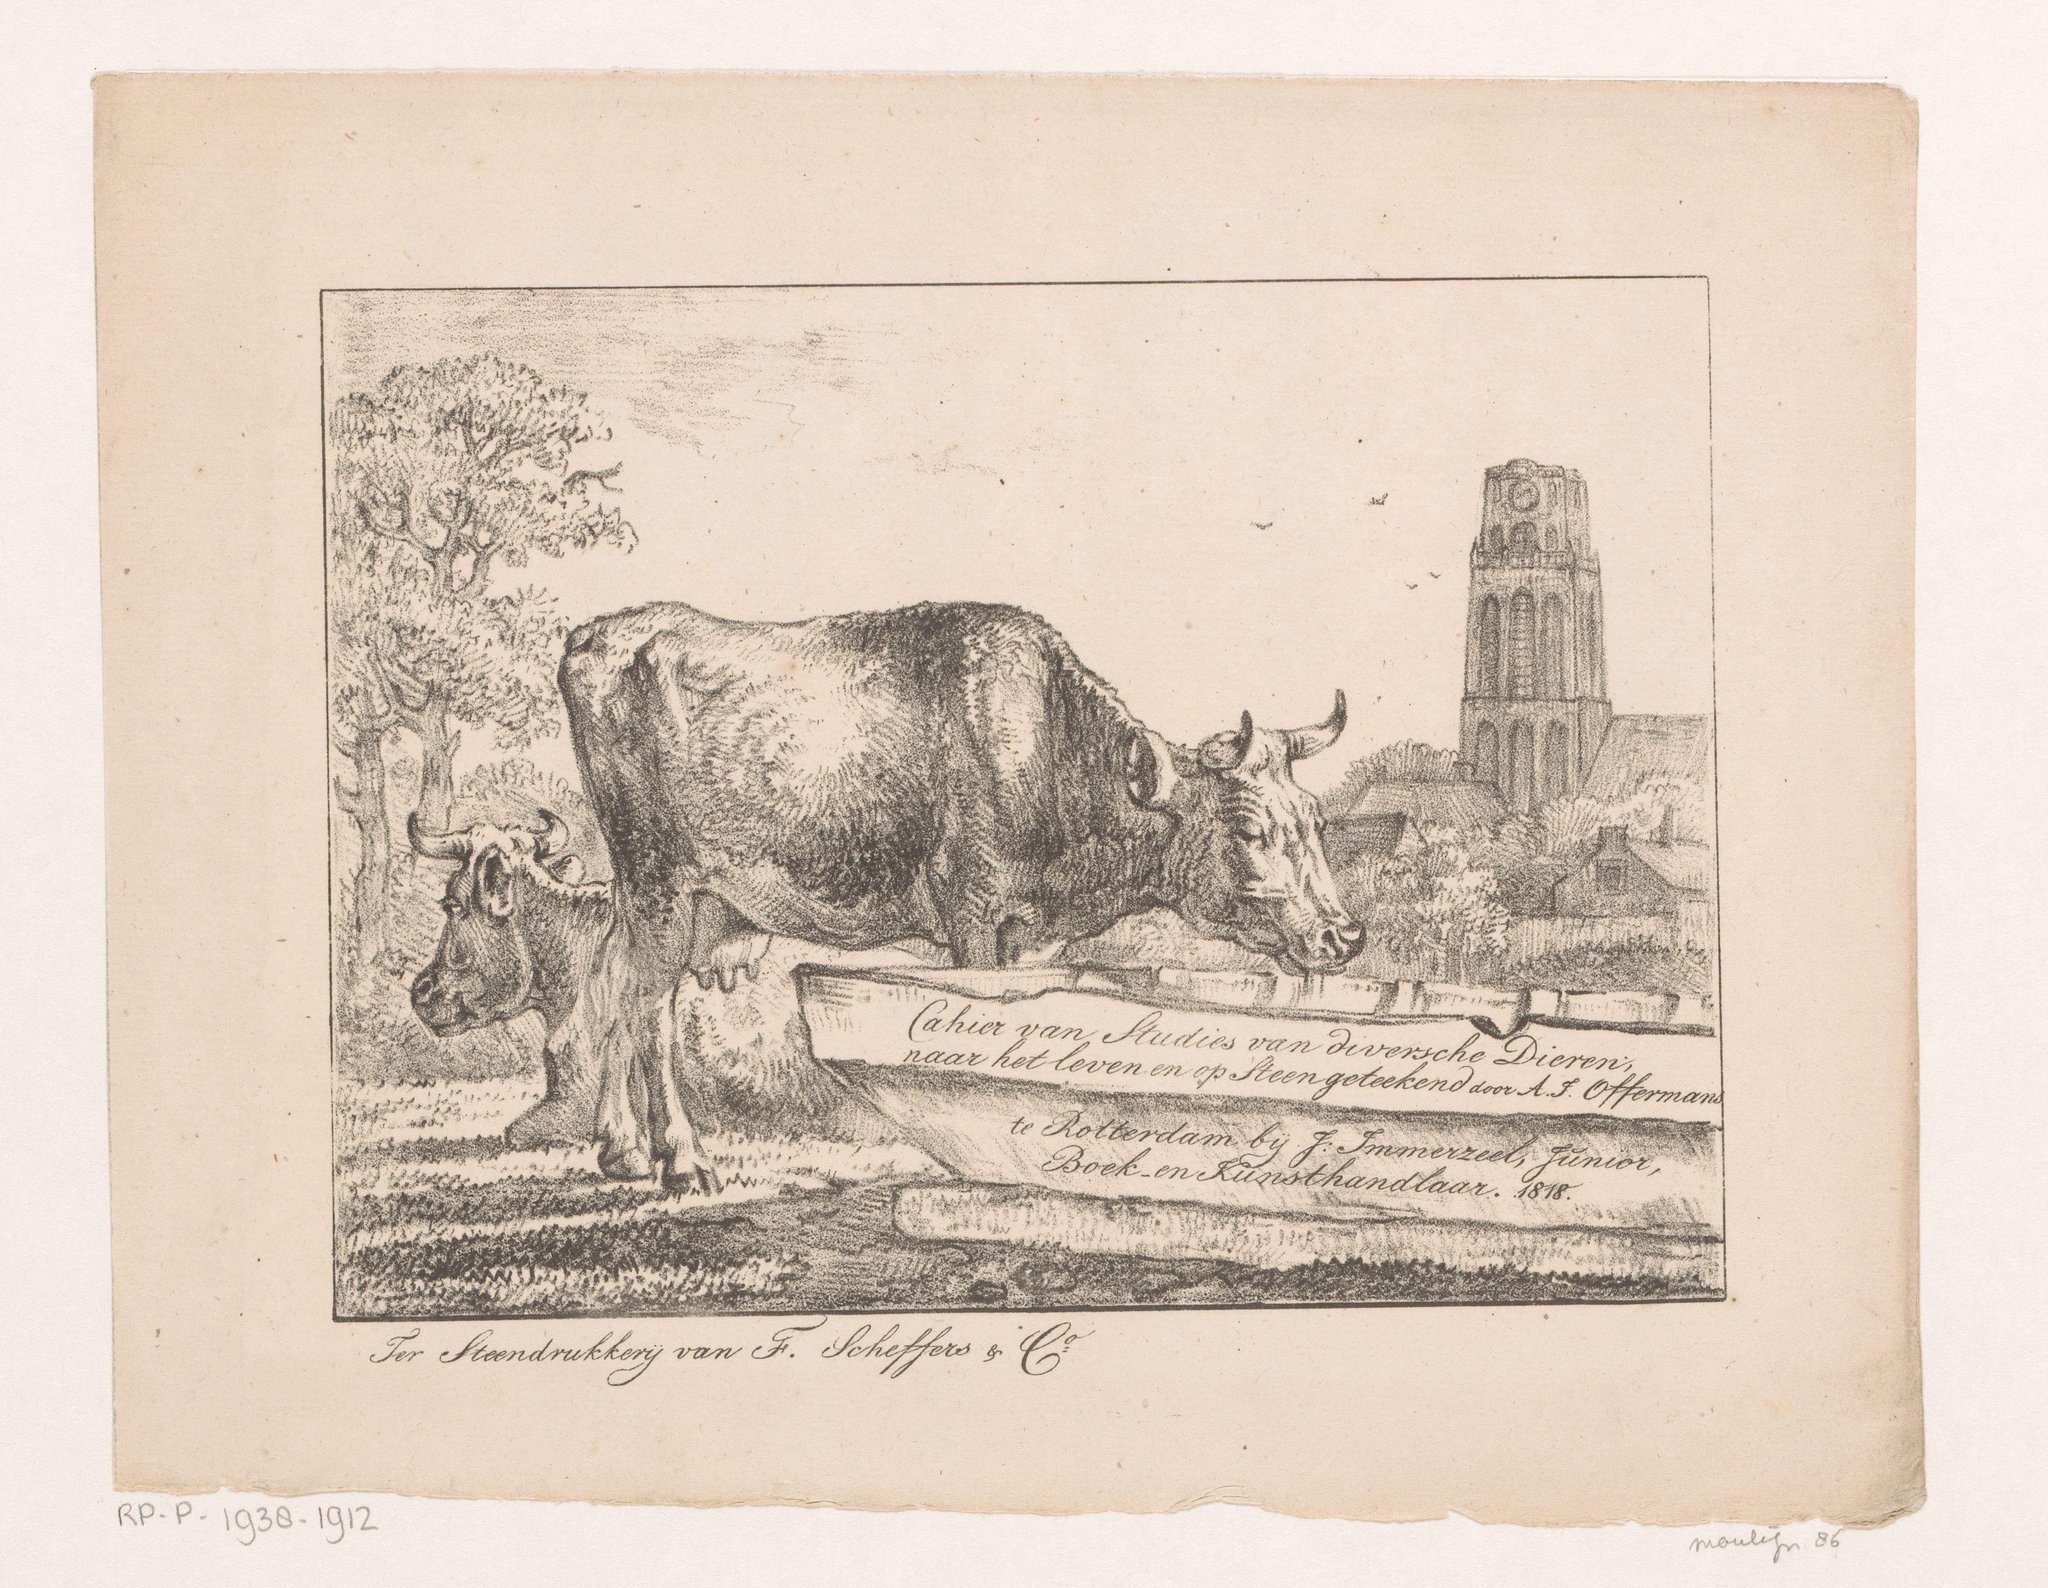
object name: titelprent, frontispice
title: Koe aan trog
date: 1818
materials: paper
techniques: lithograph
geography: rotterdam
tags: trough, cow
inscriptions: collector's mark: Lugt 2228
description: In een wei een liggende koe en een staande koe aan een trog, waarop de titel staat. In de achtergrond huizen en een kerktoren van Rotterdam.